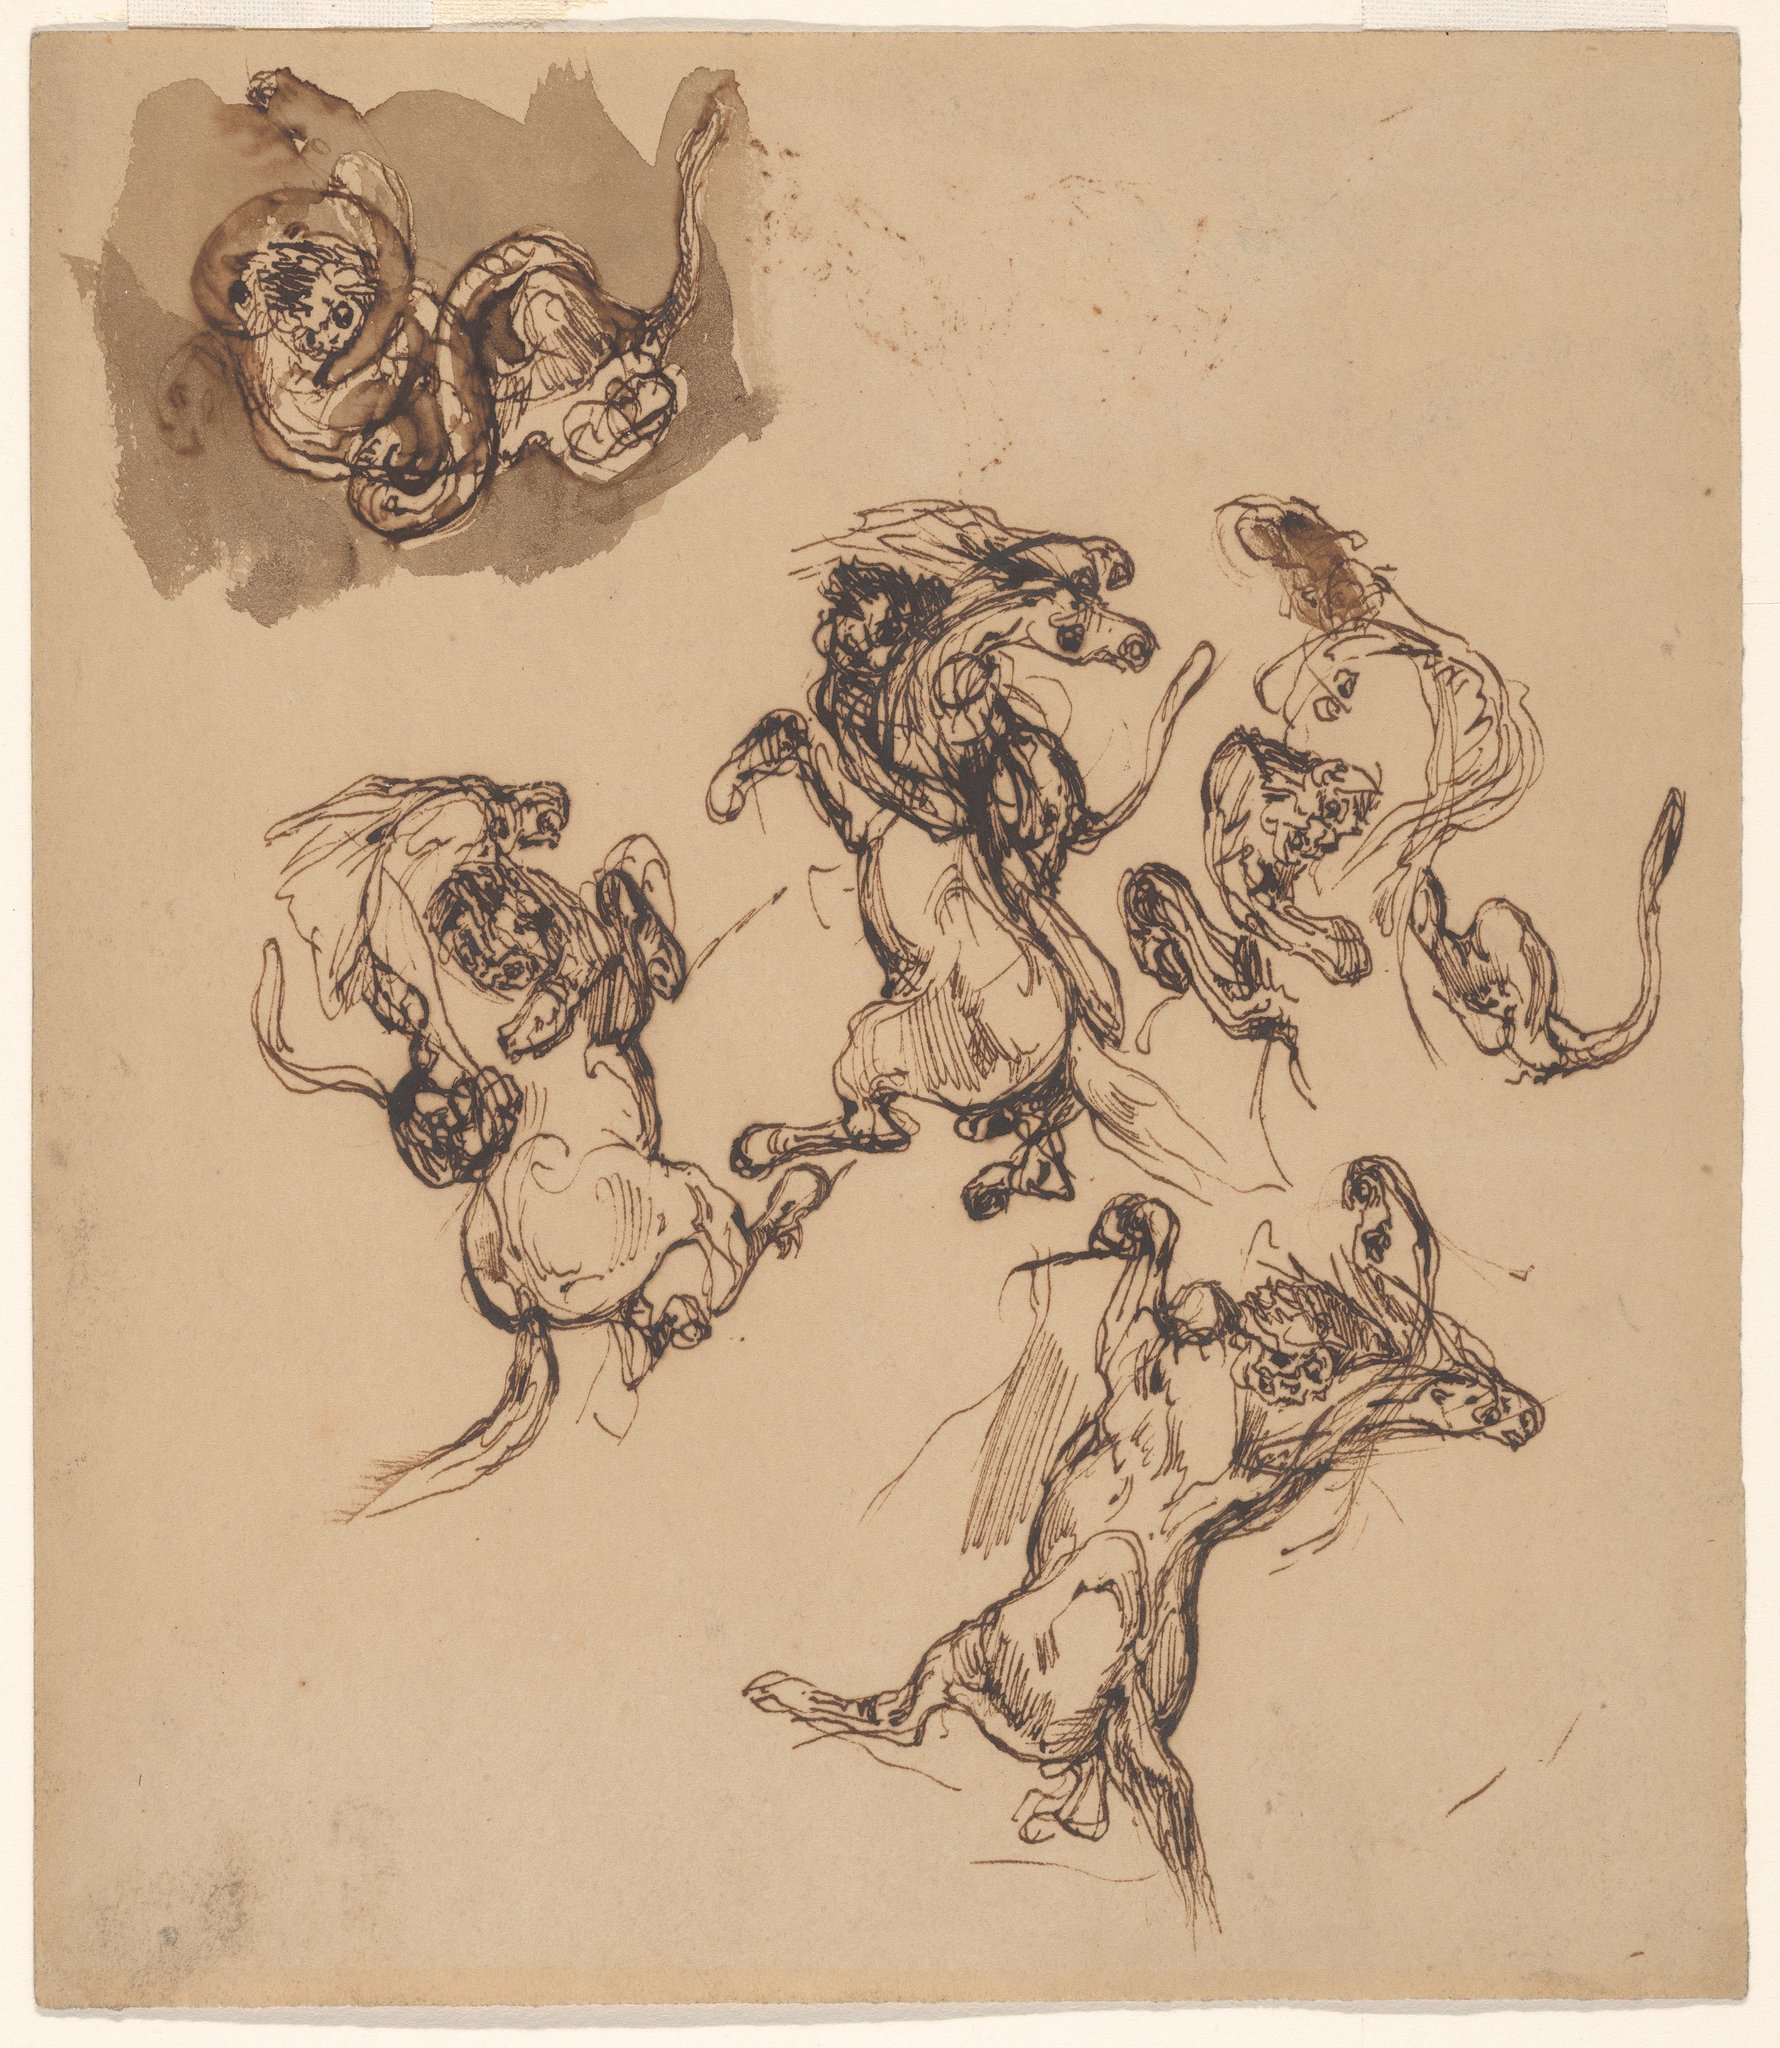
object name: drawing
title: Studies of a Rearing Horse Attacked by a Lion and a Lion Wrestling with a Serpent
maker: eugène delacroix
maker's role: artist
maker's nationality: french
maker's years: 1798-1863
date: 1830-1839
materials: ink, paper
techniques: brush, pen, wash, writing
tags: hunting,horses,lions,serpents